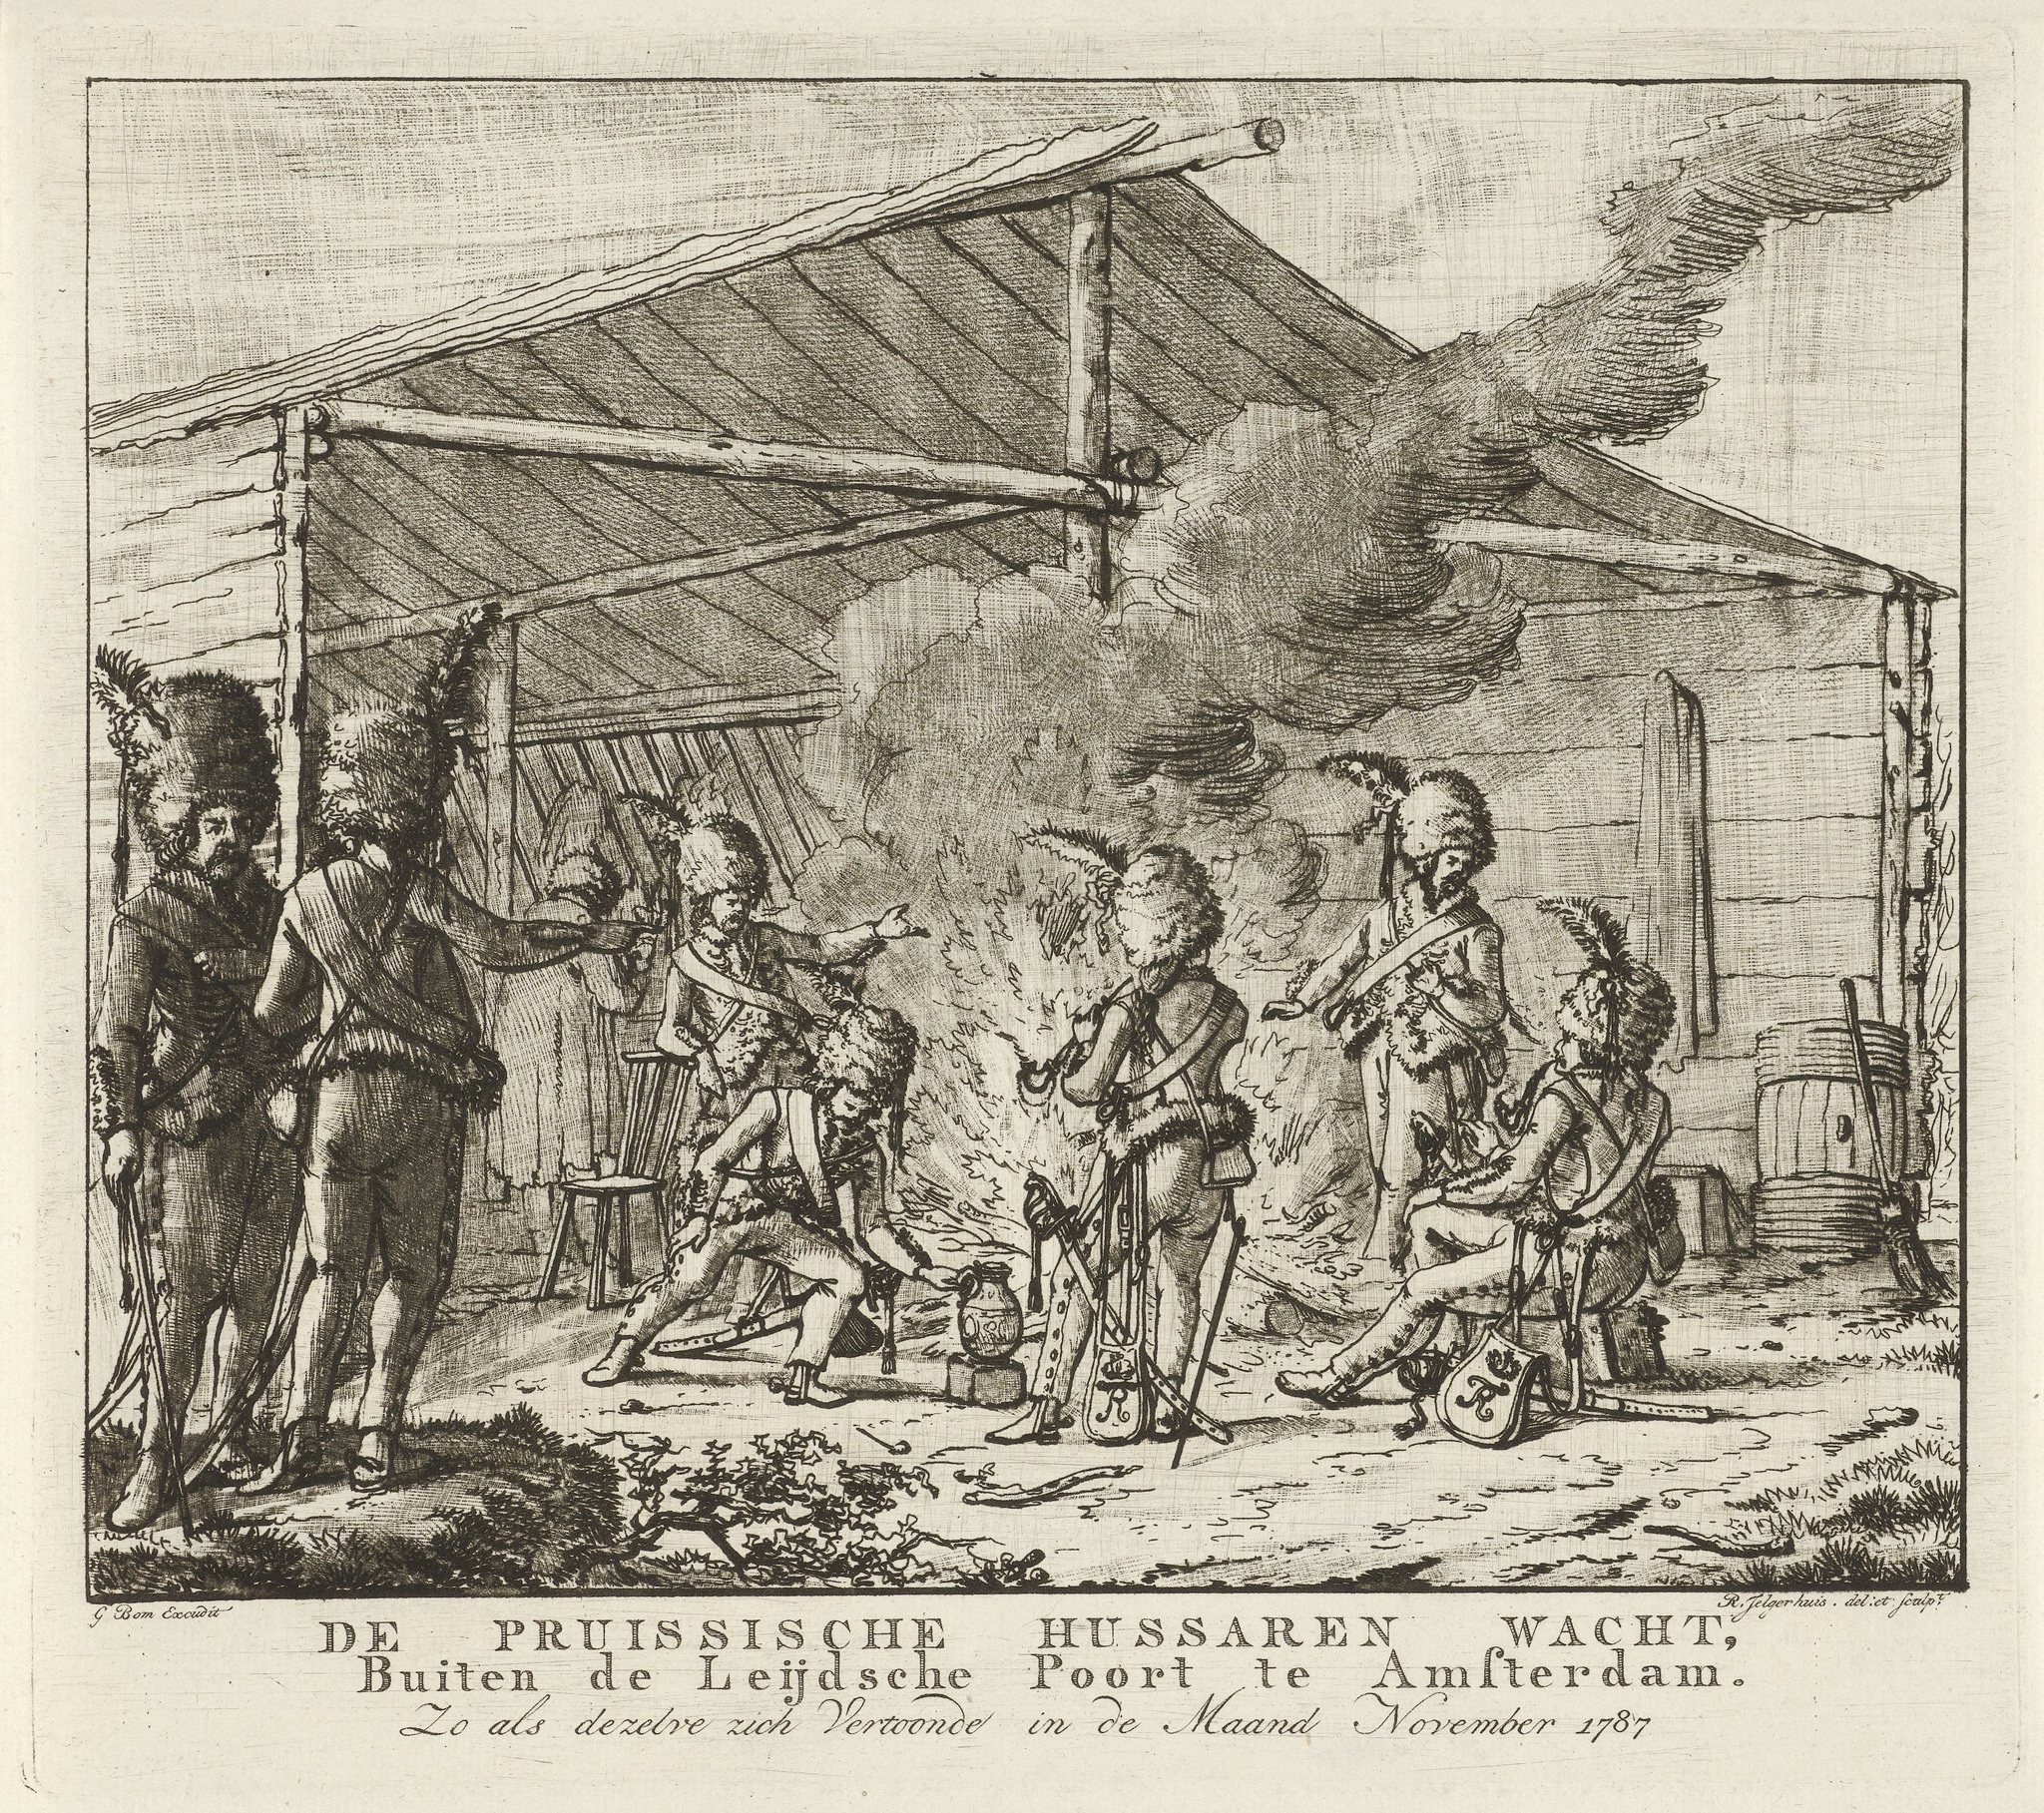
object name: history print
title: De Pruissische hussaren wacht, Buiten de Leijdsche Poort te Amsterdam (...)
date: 1787-1789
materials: paper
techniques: etching, roulette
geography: leeuwarden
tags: amsterdam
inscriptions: collector's mark: Lugt 2228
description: Gezicht op de Pruisische huzarenwacht bij de Leidse Poort te Amsterdam, ten tijde van november 1787. In de marge een tweeregelige tekst in het Nederlands.